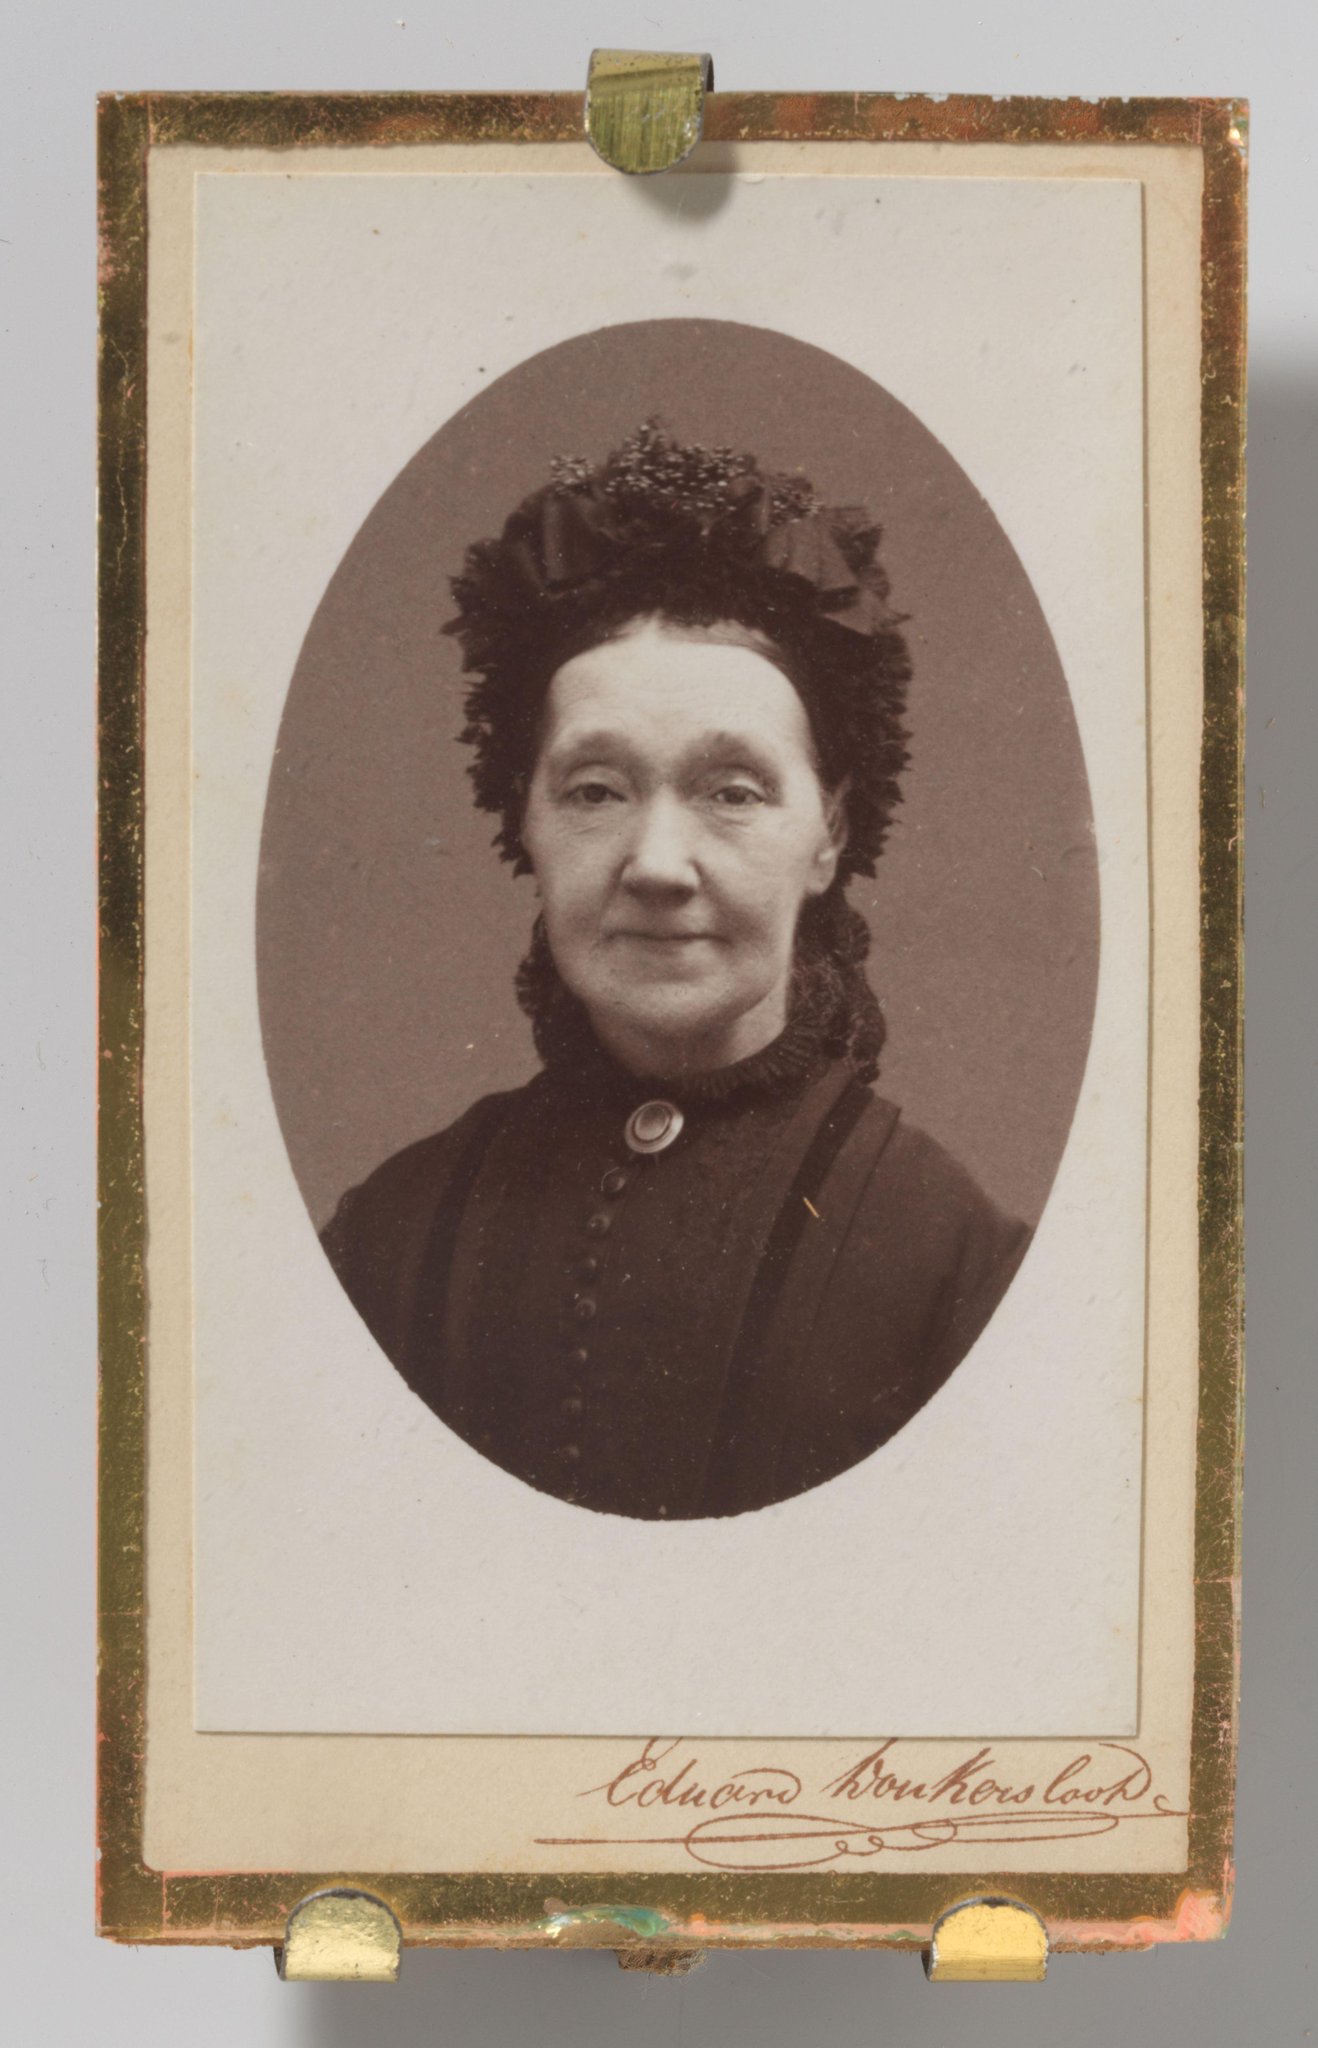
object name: photograph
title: Portret van een onbekende vrouw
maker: eduard donkersloot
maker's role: fotograaf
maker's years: 1860-1907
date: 1880-1907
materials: cardboard, glass, metal, paper, wood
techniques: albumen print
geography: netherlands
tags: adult woman, anonymous historical person portrayed, netherlands